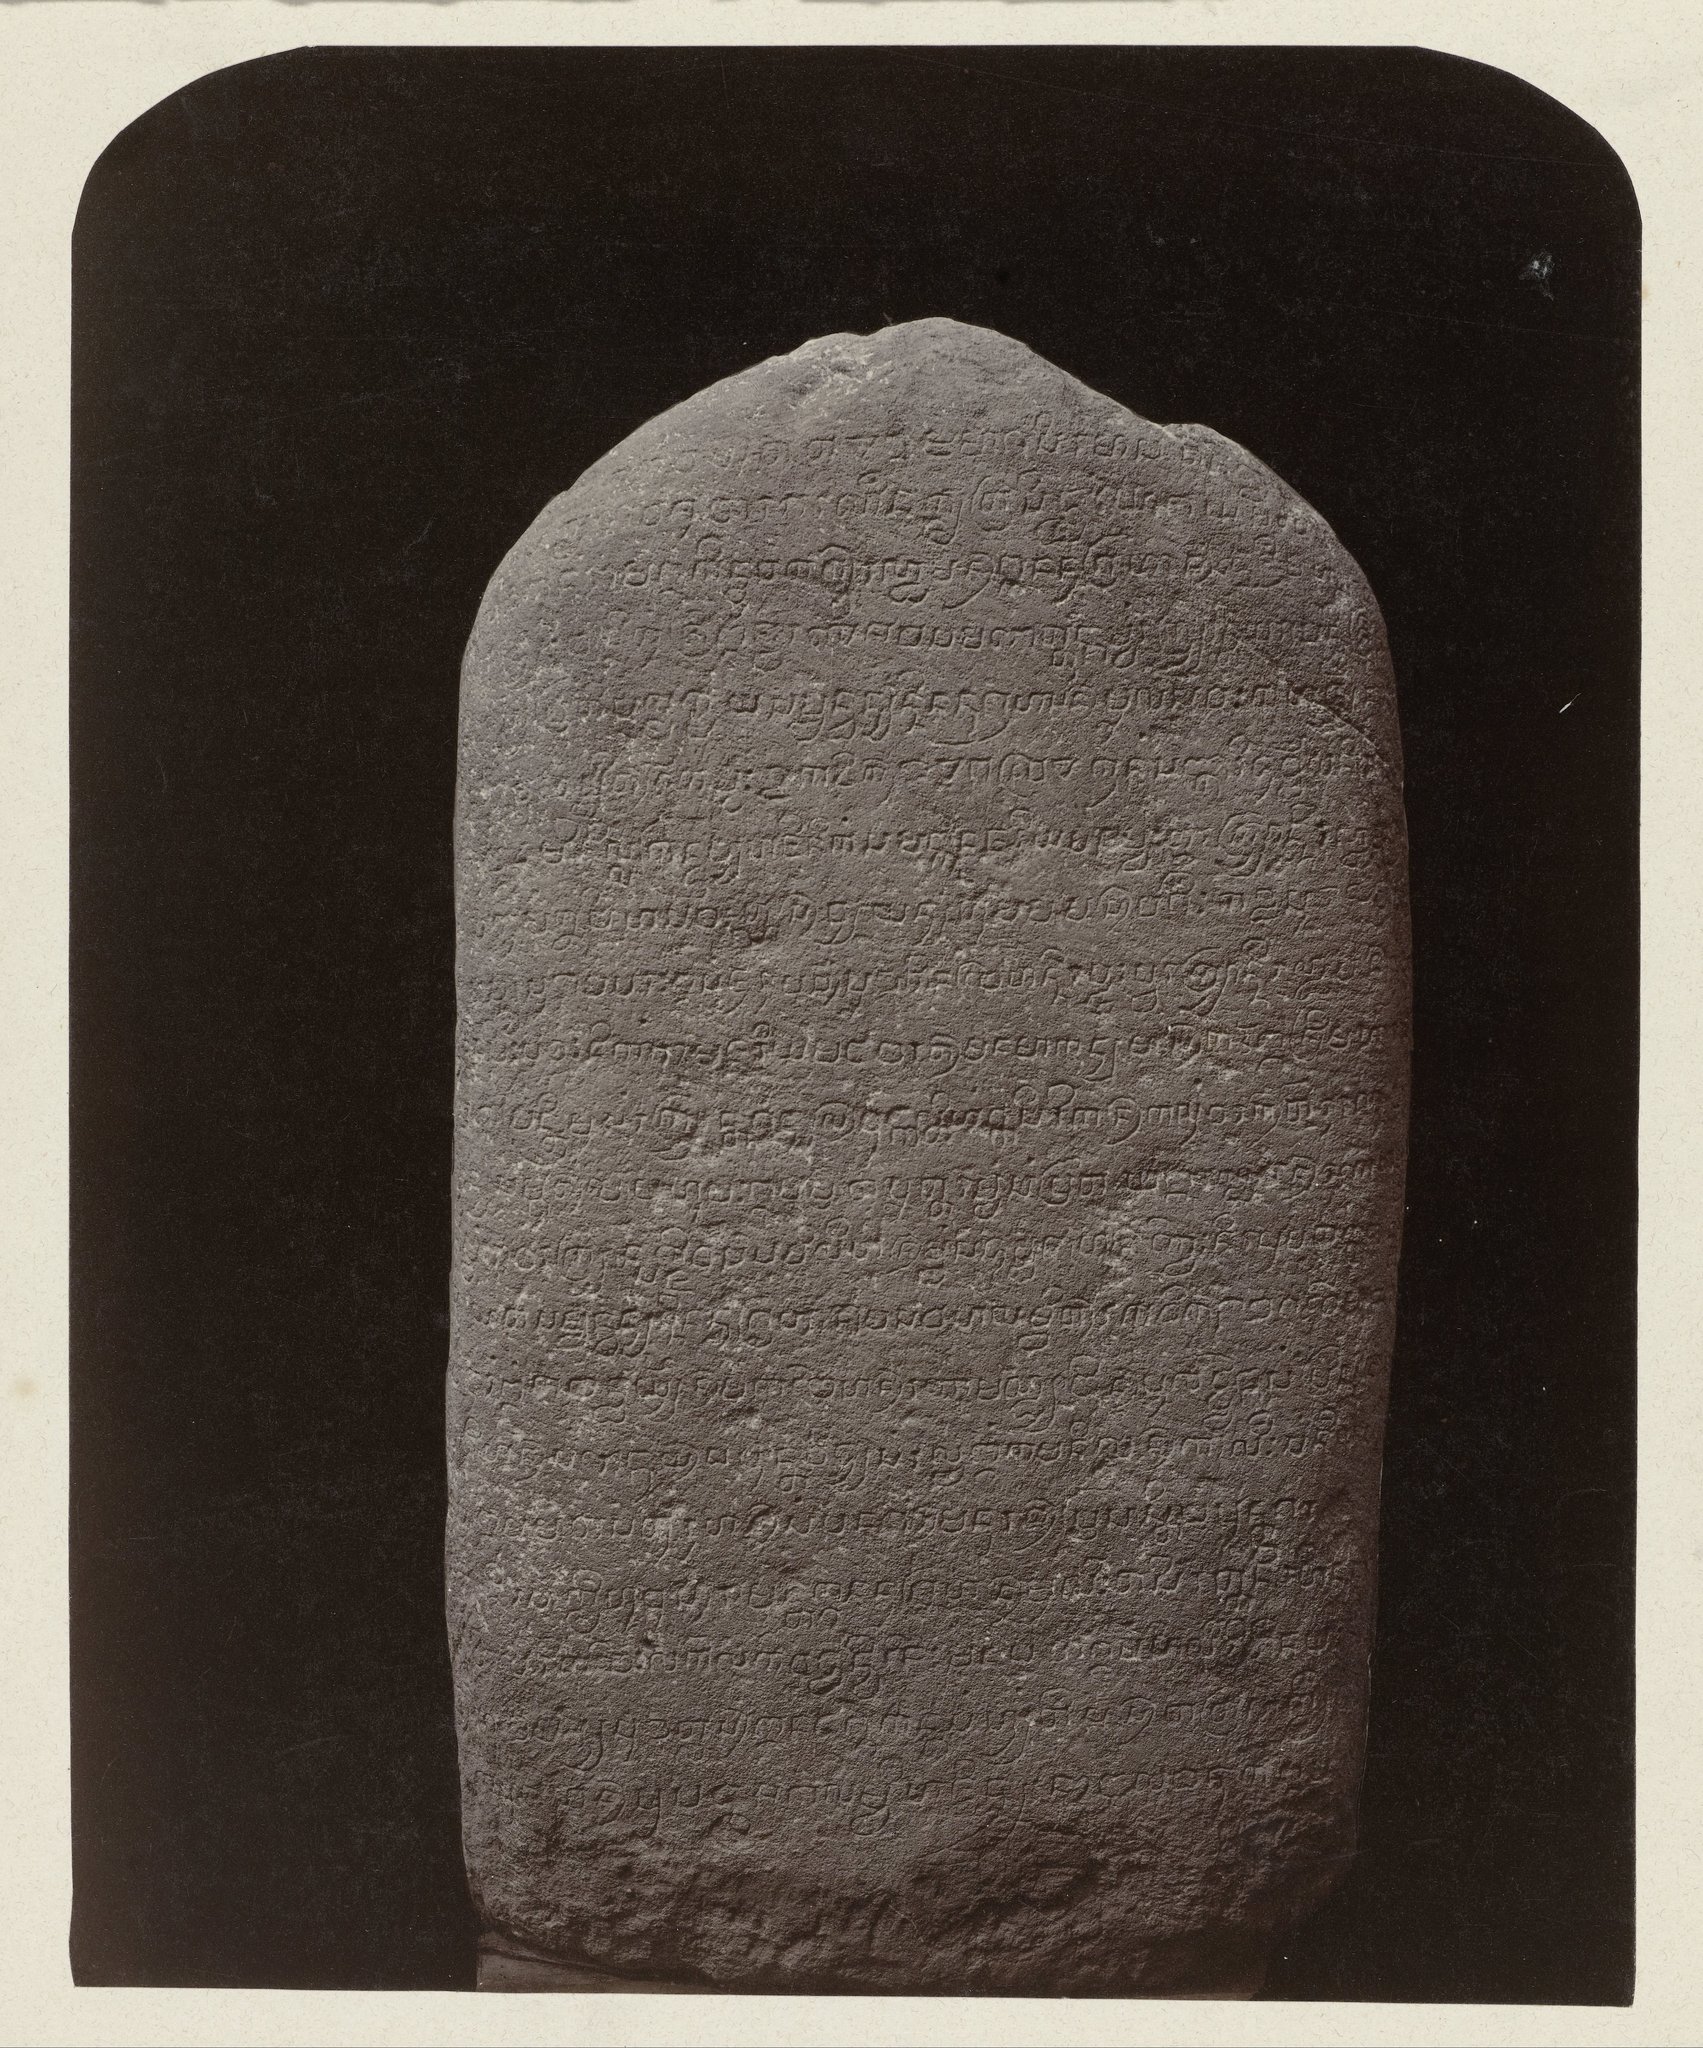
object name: photograph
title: Beschreven steen. Panataran (r. Kediri)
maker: isidore kinsbergen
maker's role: fotograaf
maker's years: 1821-1905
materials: cardboard, paper, photographic support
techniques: albumen print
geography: java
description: Inscribed Ganesha stele (rear view). Blitar, Blitar district, East Java province, 10th century